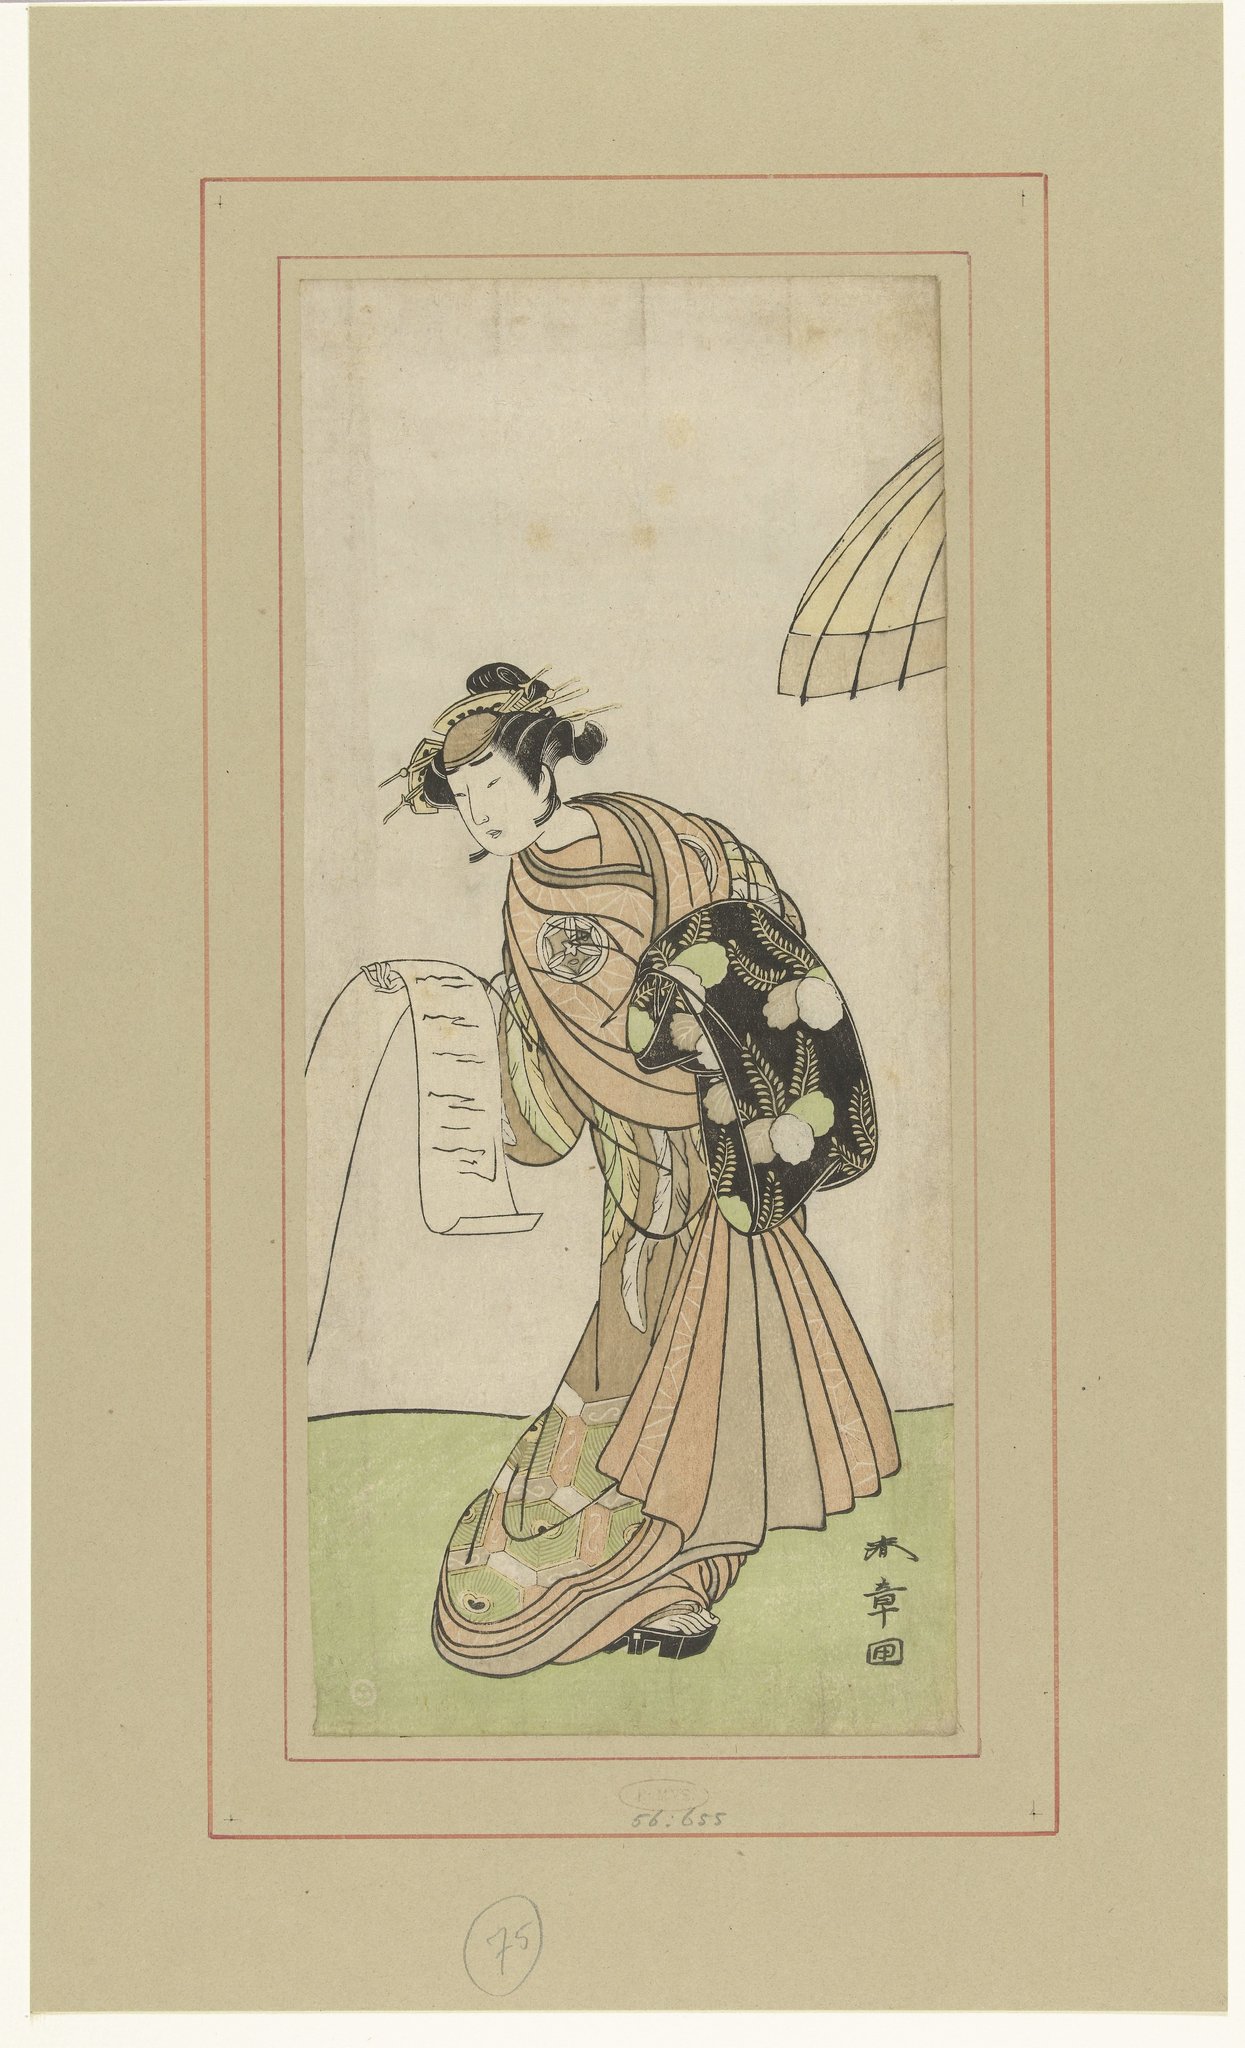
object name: print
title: Acteur Yamashita Kinsaku II in de rol van de courtisane Agemaki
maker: katsukawa shunsho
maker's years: 1726-1792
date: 1773-1777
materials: paper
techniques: woodcut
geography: japan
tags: portrait of actor, actress, actor (on the stage), letter, envelope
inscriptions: collector's mark: Lugt 2228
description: Courtisane met in rechter hand een lange brief; rechts een deel van een paraplu. Middelste blad van triptiek.